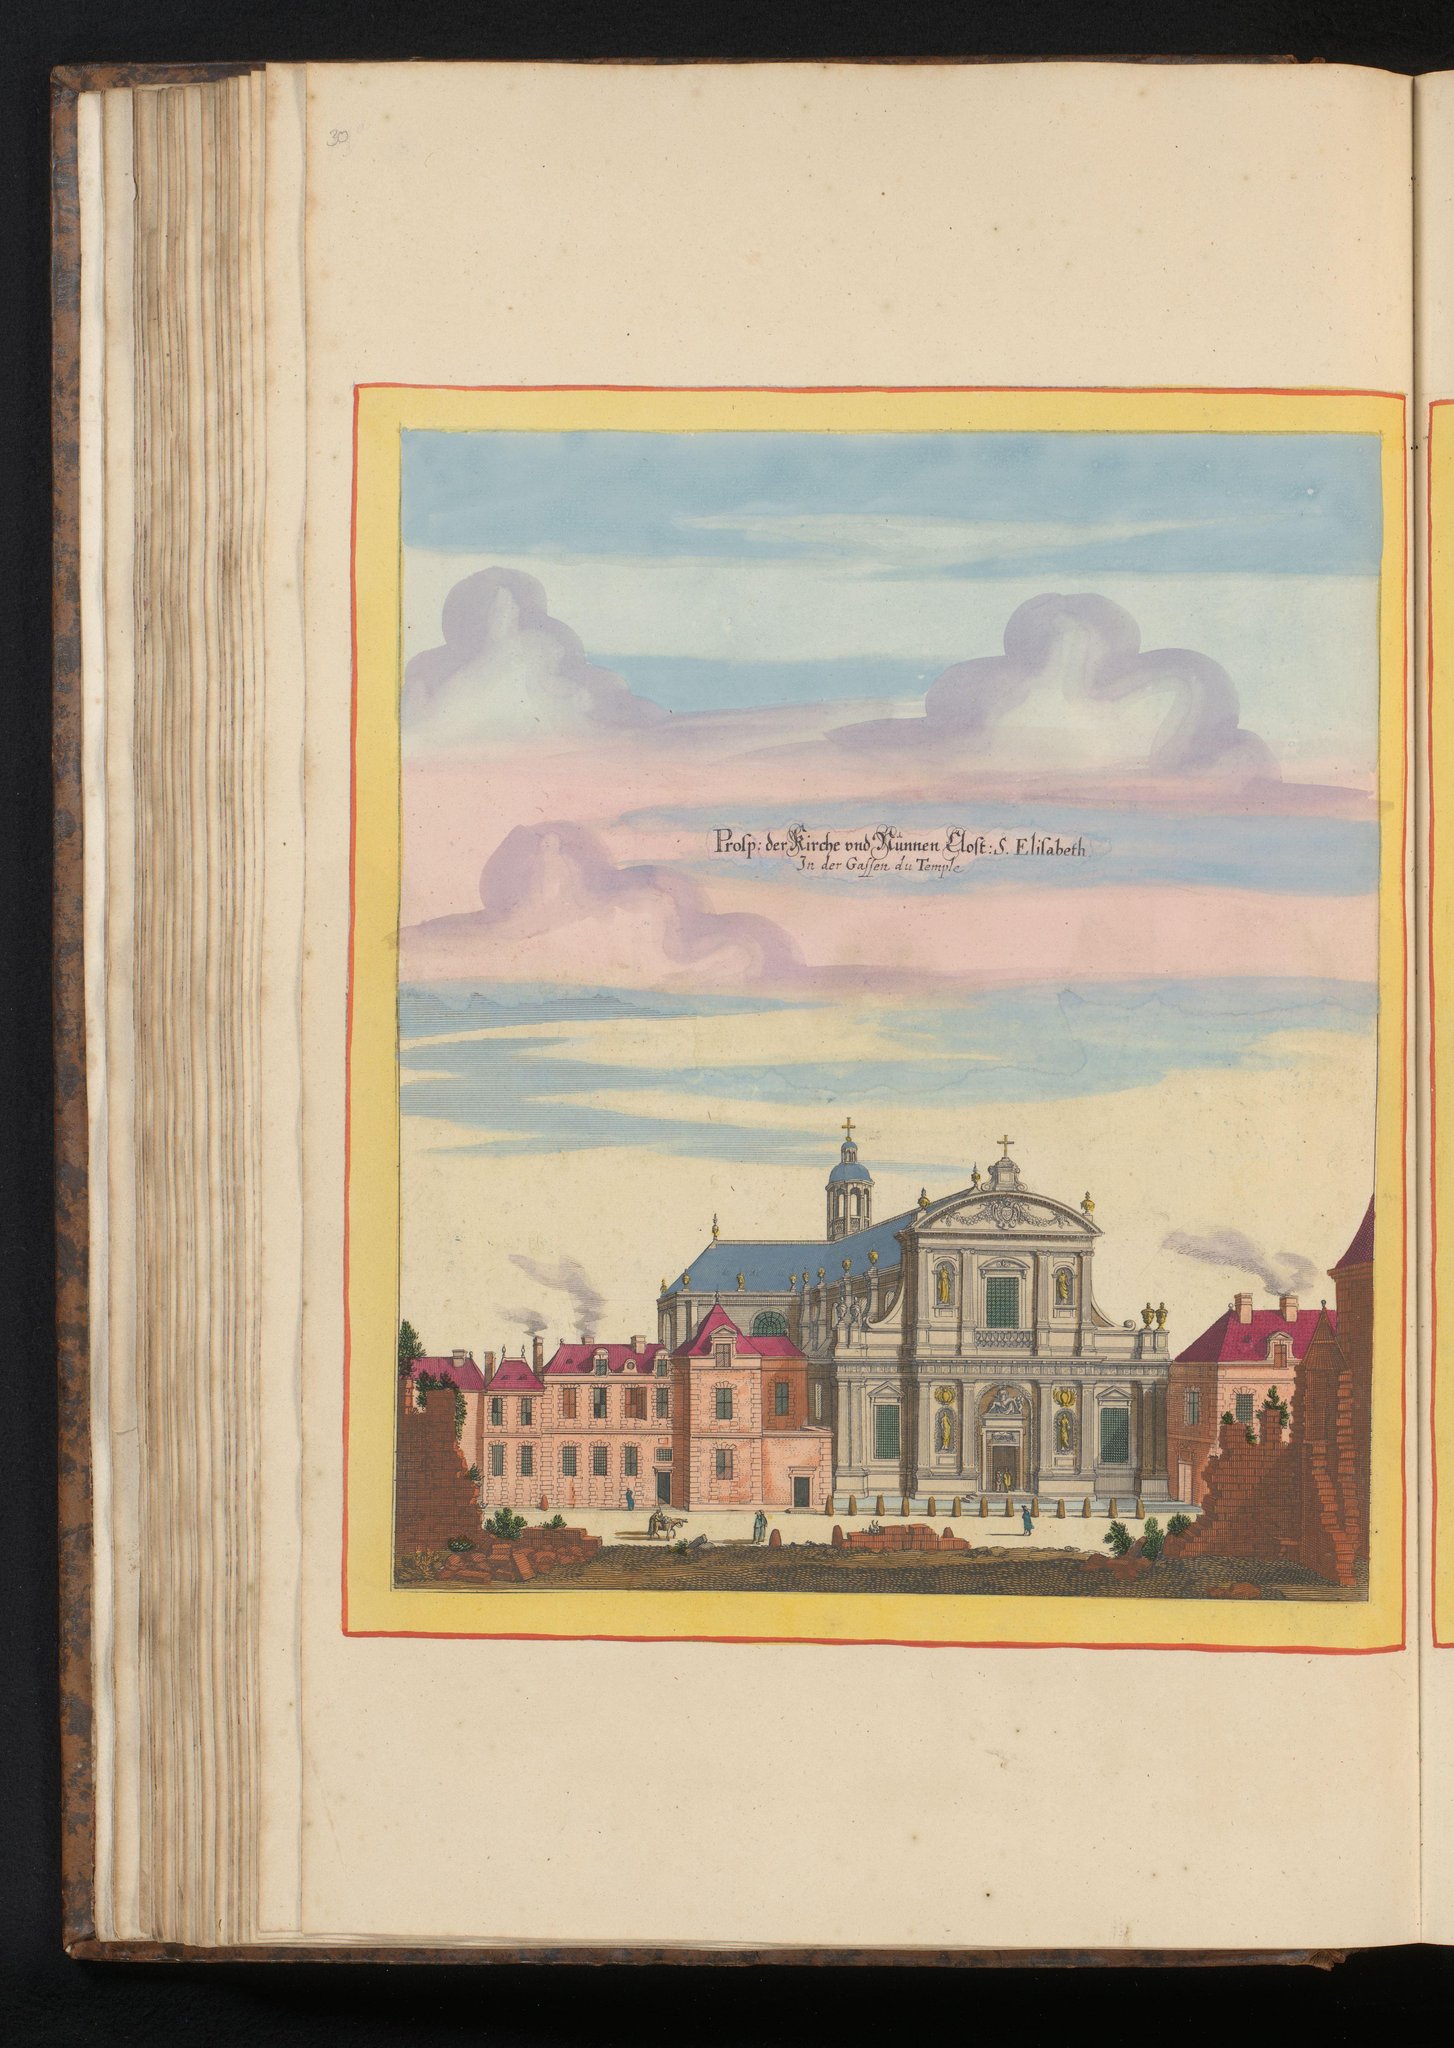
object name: album leaf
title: Prosp. der Kirche und Nunnen Clost: S. Elisabeth In der Gassen du Temple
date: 1655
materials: paper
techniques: engraving, etching, hand coloring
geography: frankfurt am main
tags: church (exterior)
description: Prent origineel vervaardigd als boekillustratie voor: Zeiller, Martin. Topographia Galliae, oder Beschreibung und Contrafaitung der vornehmbsten und bekantisten Oerter in dem mächtigen und grossen Königreich Frankreich, 13 delen. Frankfurt am Main: Caspar Merian, 1655-1661. De prent werd voor het eerst gepubliceerd in deel 1: Topographia Galliae, 1655.